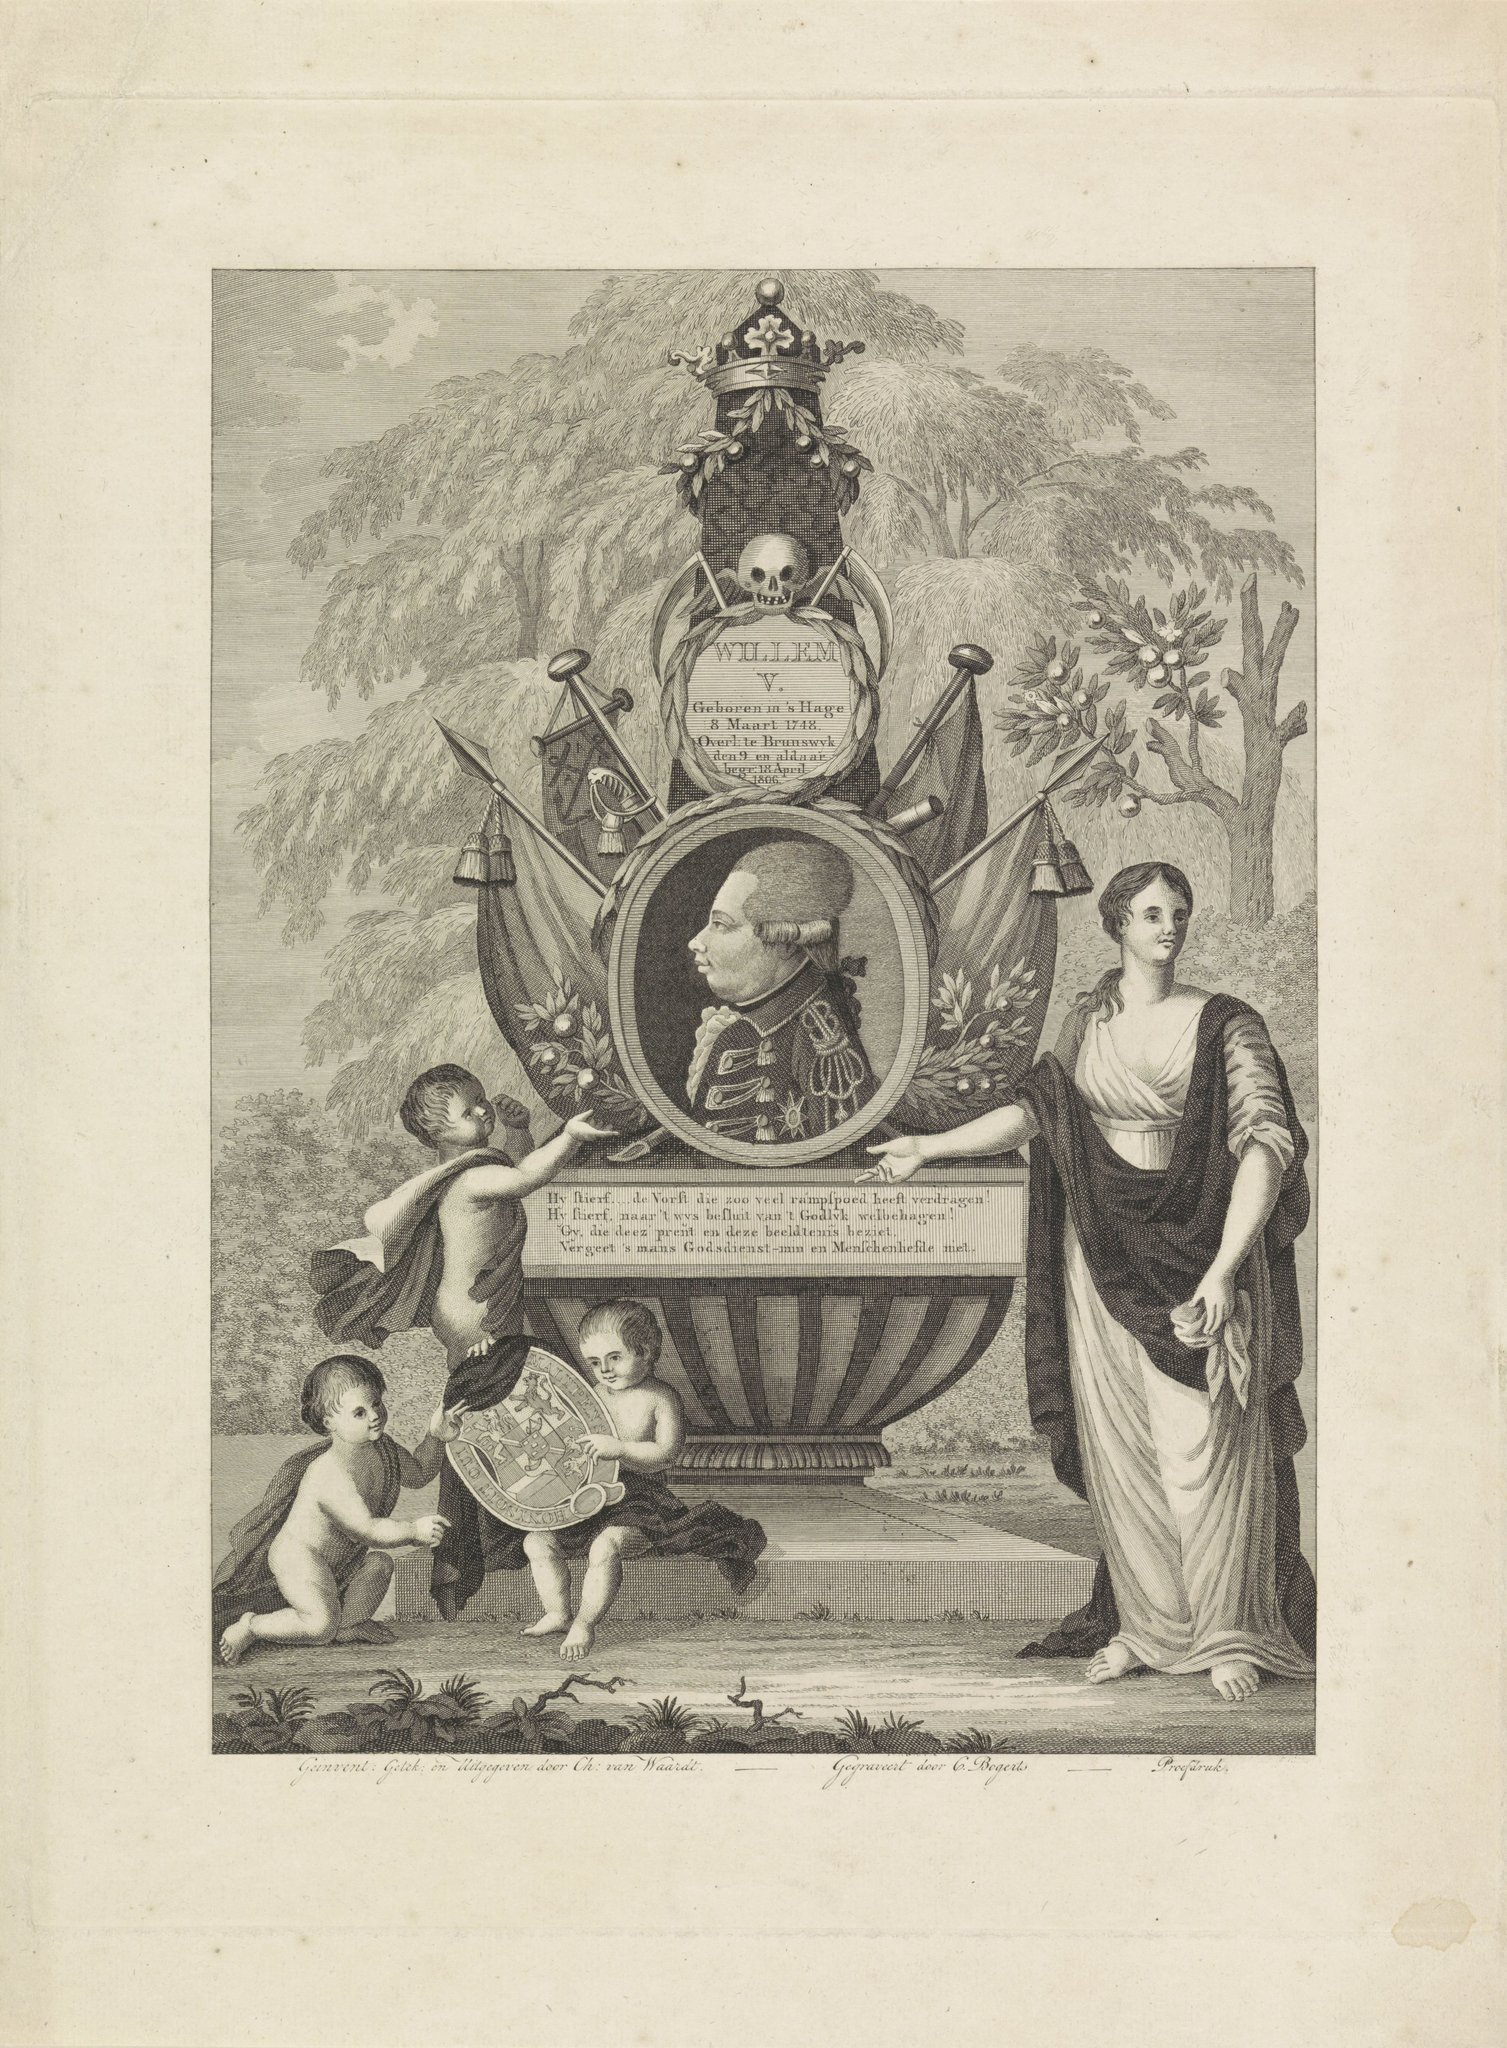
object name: print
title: Allegorisch grafmonument voor prins Willem V, 1806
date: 1806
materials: paper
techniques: engraving, etching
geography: netherlands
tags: the hague, william v (prince of orange), grave-building, monumental tomb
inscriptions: collector's mark: Lugt 2228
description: Grafmonument voor prins Willem V, overleden op 9 april 1806. Op het graf een ovaal portret van de prins, omgeven door vaandels en Oranjetakken. Onder het portret een vers van vier regels. De staande vrouw rechts is de Vriendschap, links drie kinderen met het wapen van de prins.